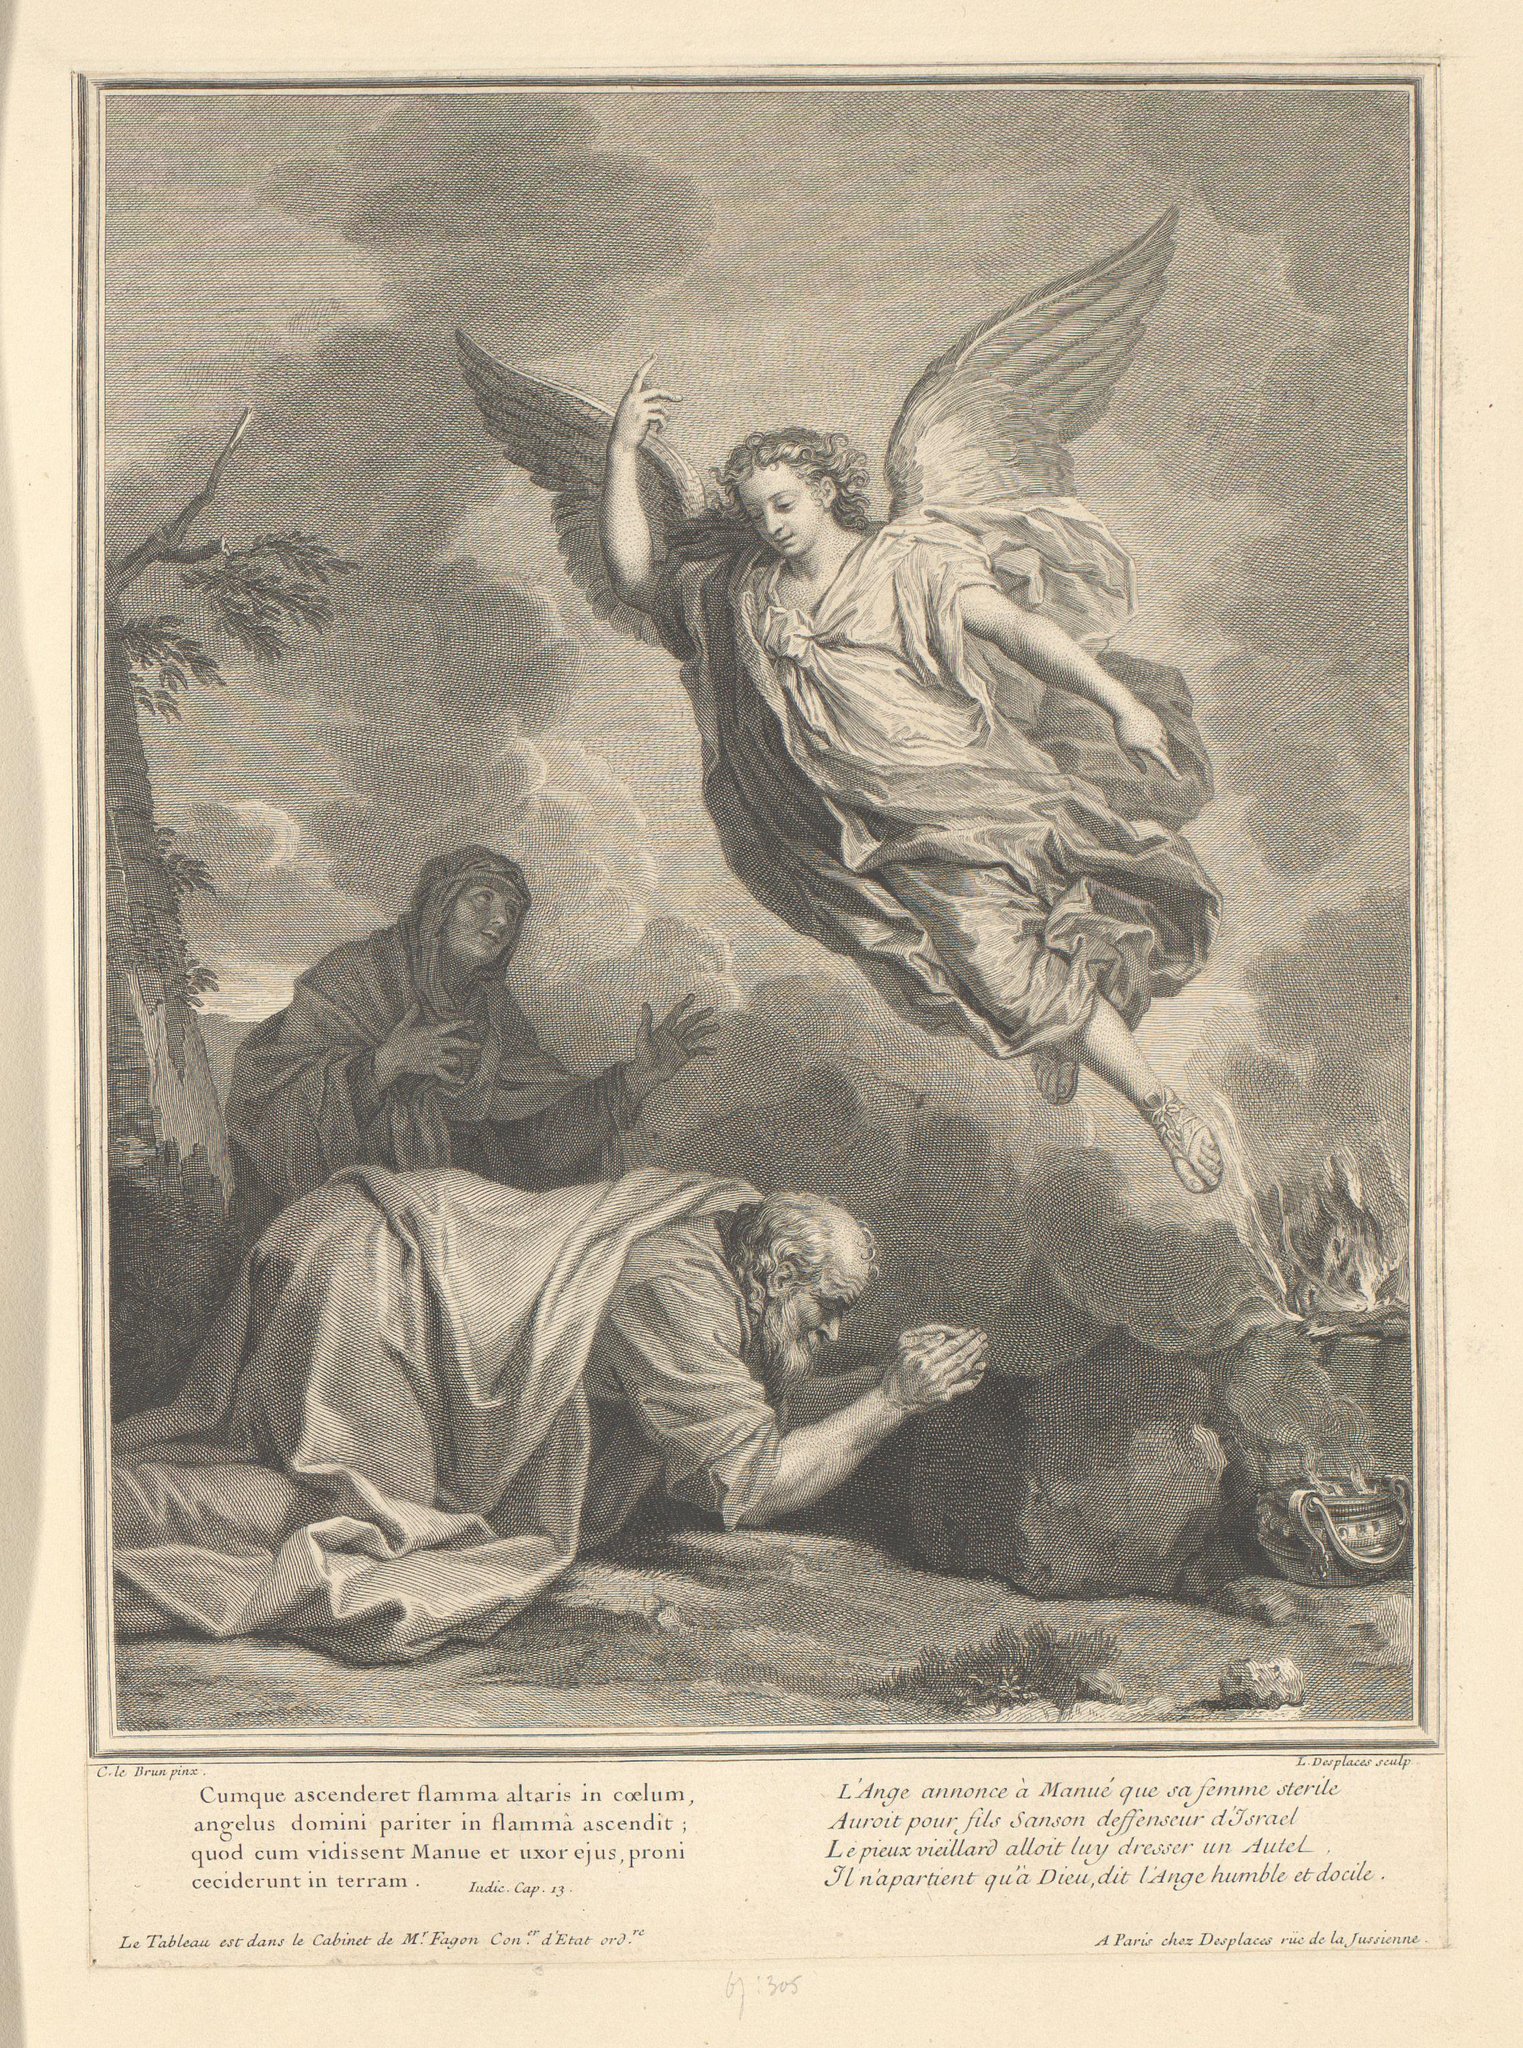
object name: album leaf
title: Werken van Charles le Brun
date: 1692-1739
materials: paper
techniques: engraving, etching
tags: manoah's sacrifice; the angel ascends in the flames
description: Deze prent maakt deel uit van een album.